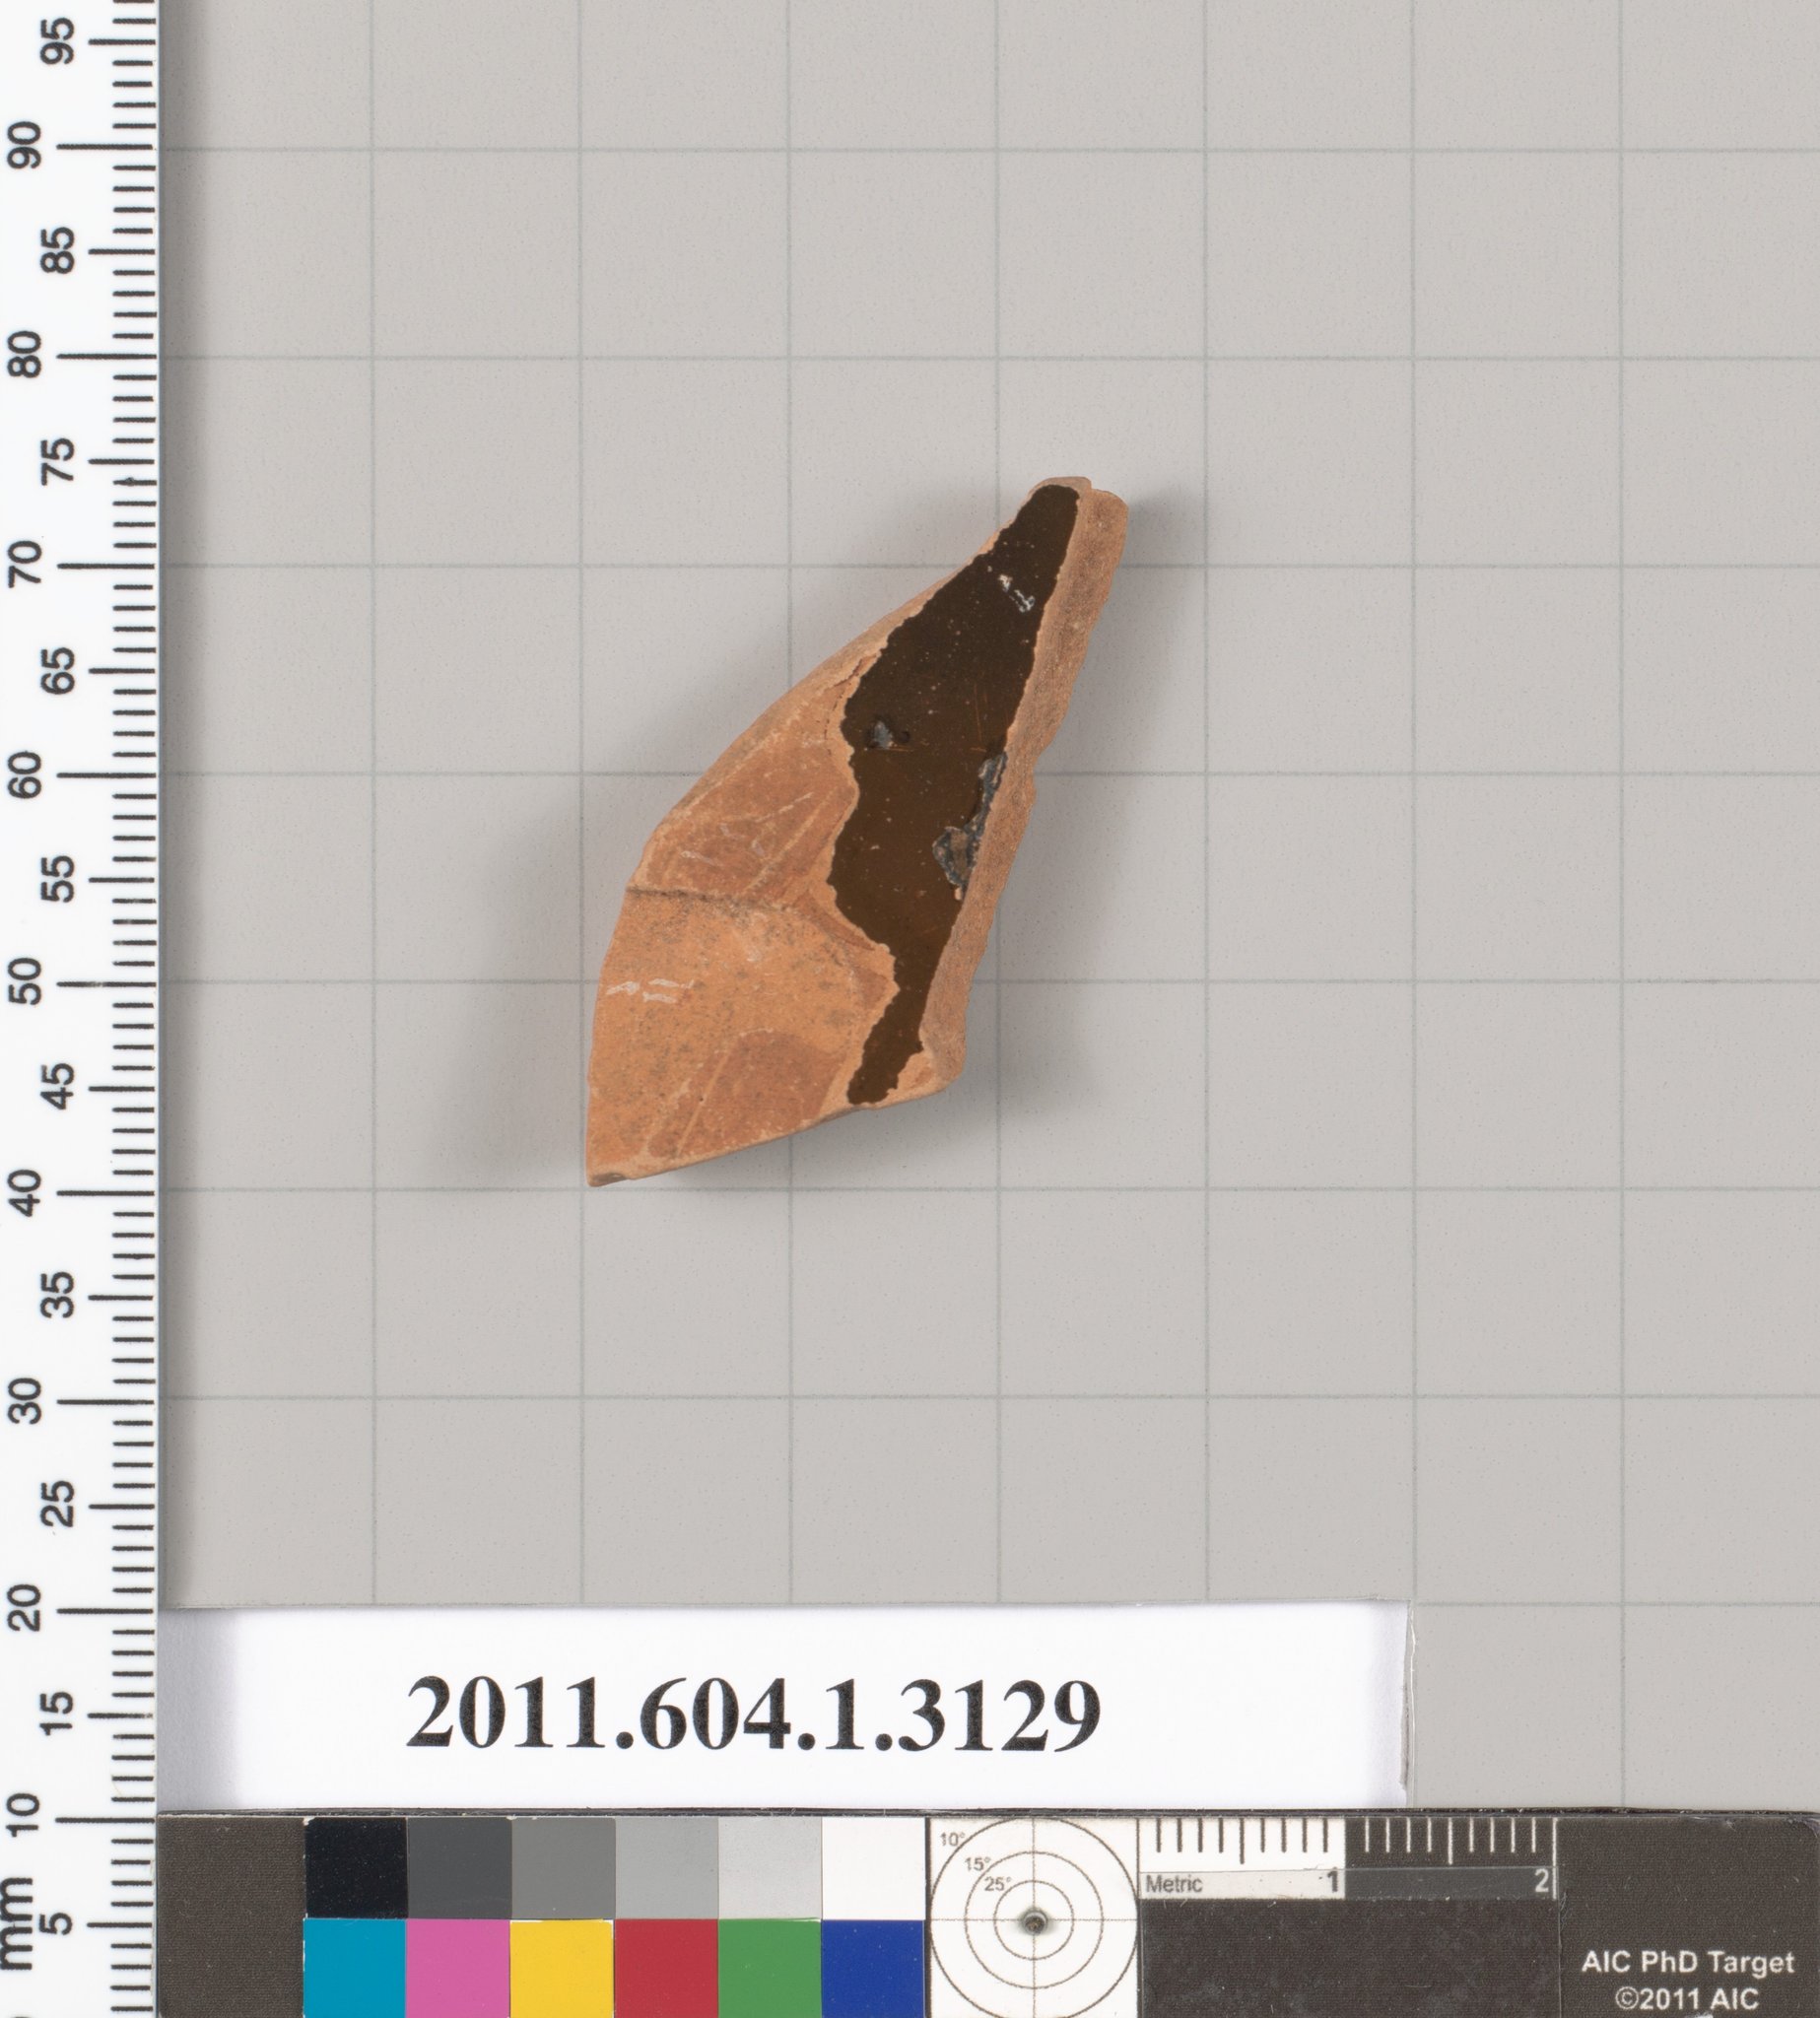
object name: kylix fragment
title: Terracotta fragment of a kylix (drinking cup)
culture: greek, attic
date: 500-451 BCE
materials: terracotta